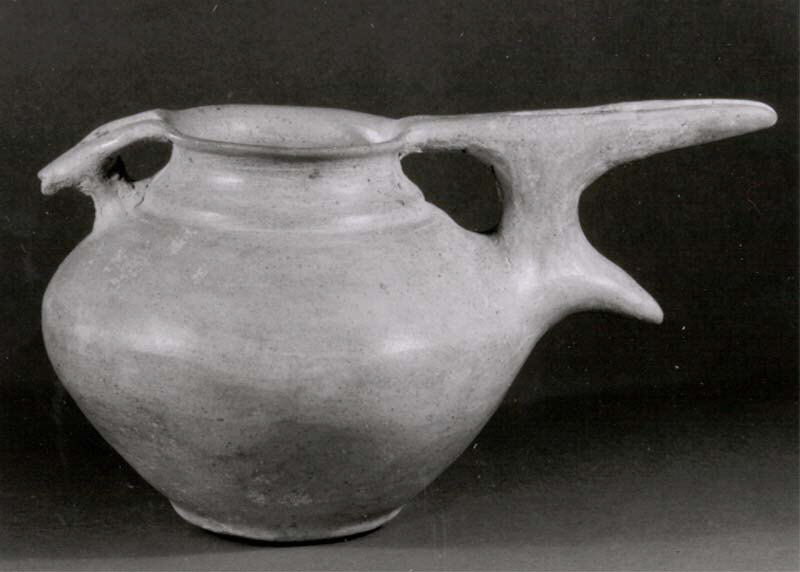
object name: pitcher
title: Bridge-spouted pitcher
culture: iranian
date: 1000-801 BCE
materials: ceramic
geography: iran